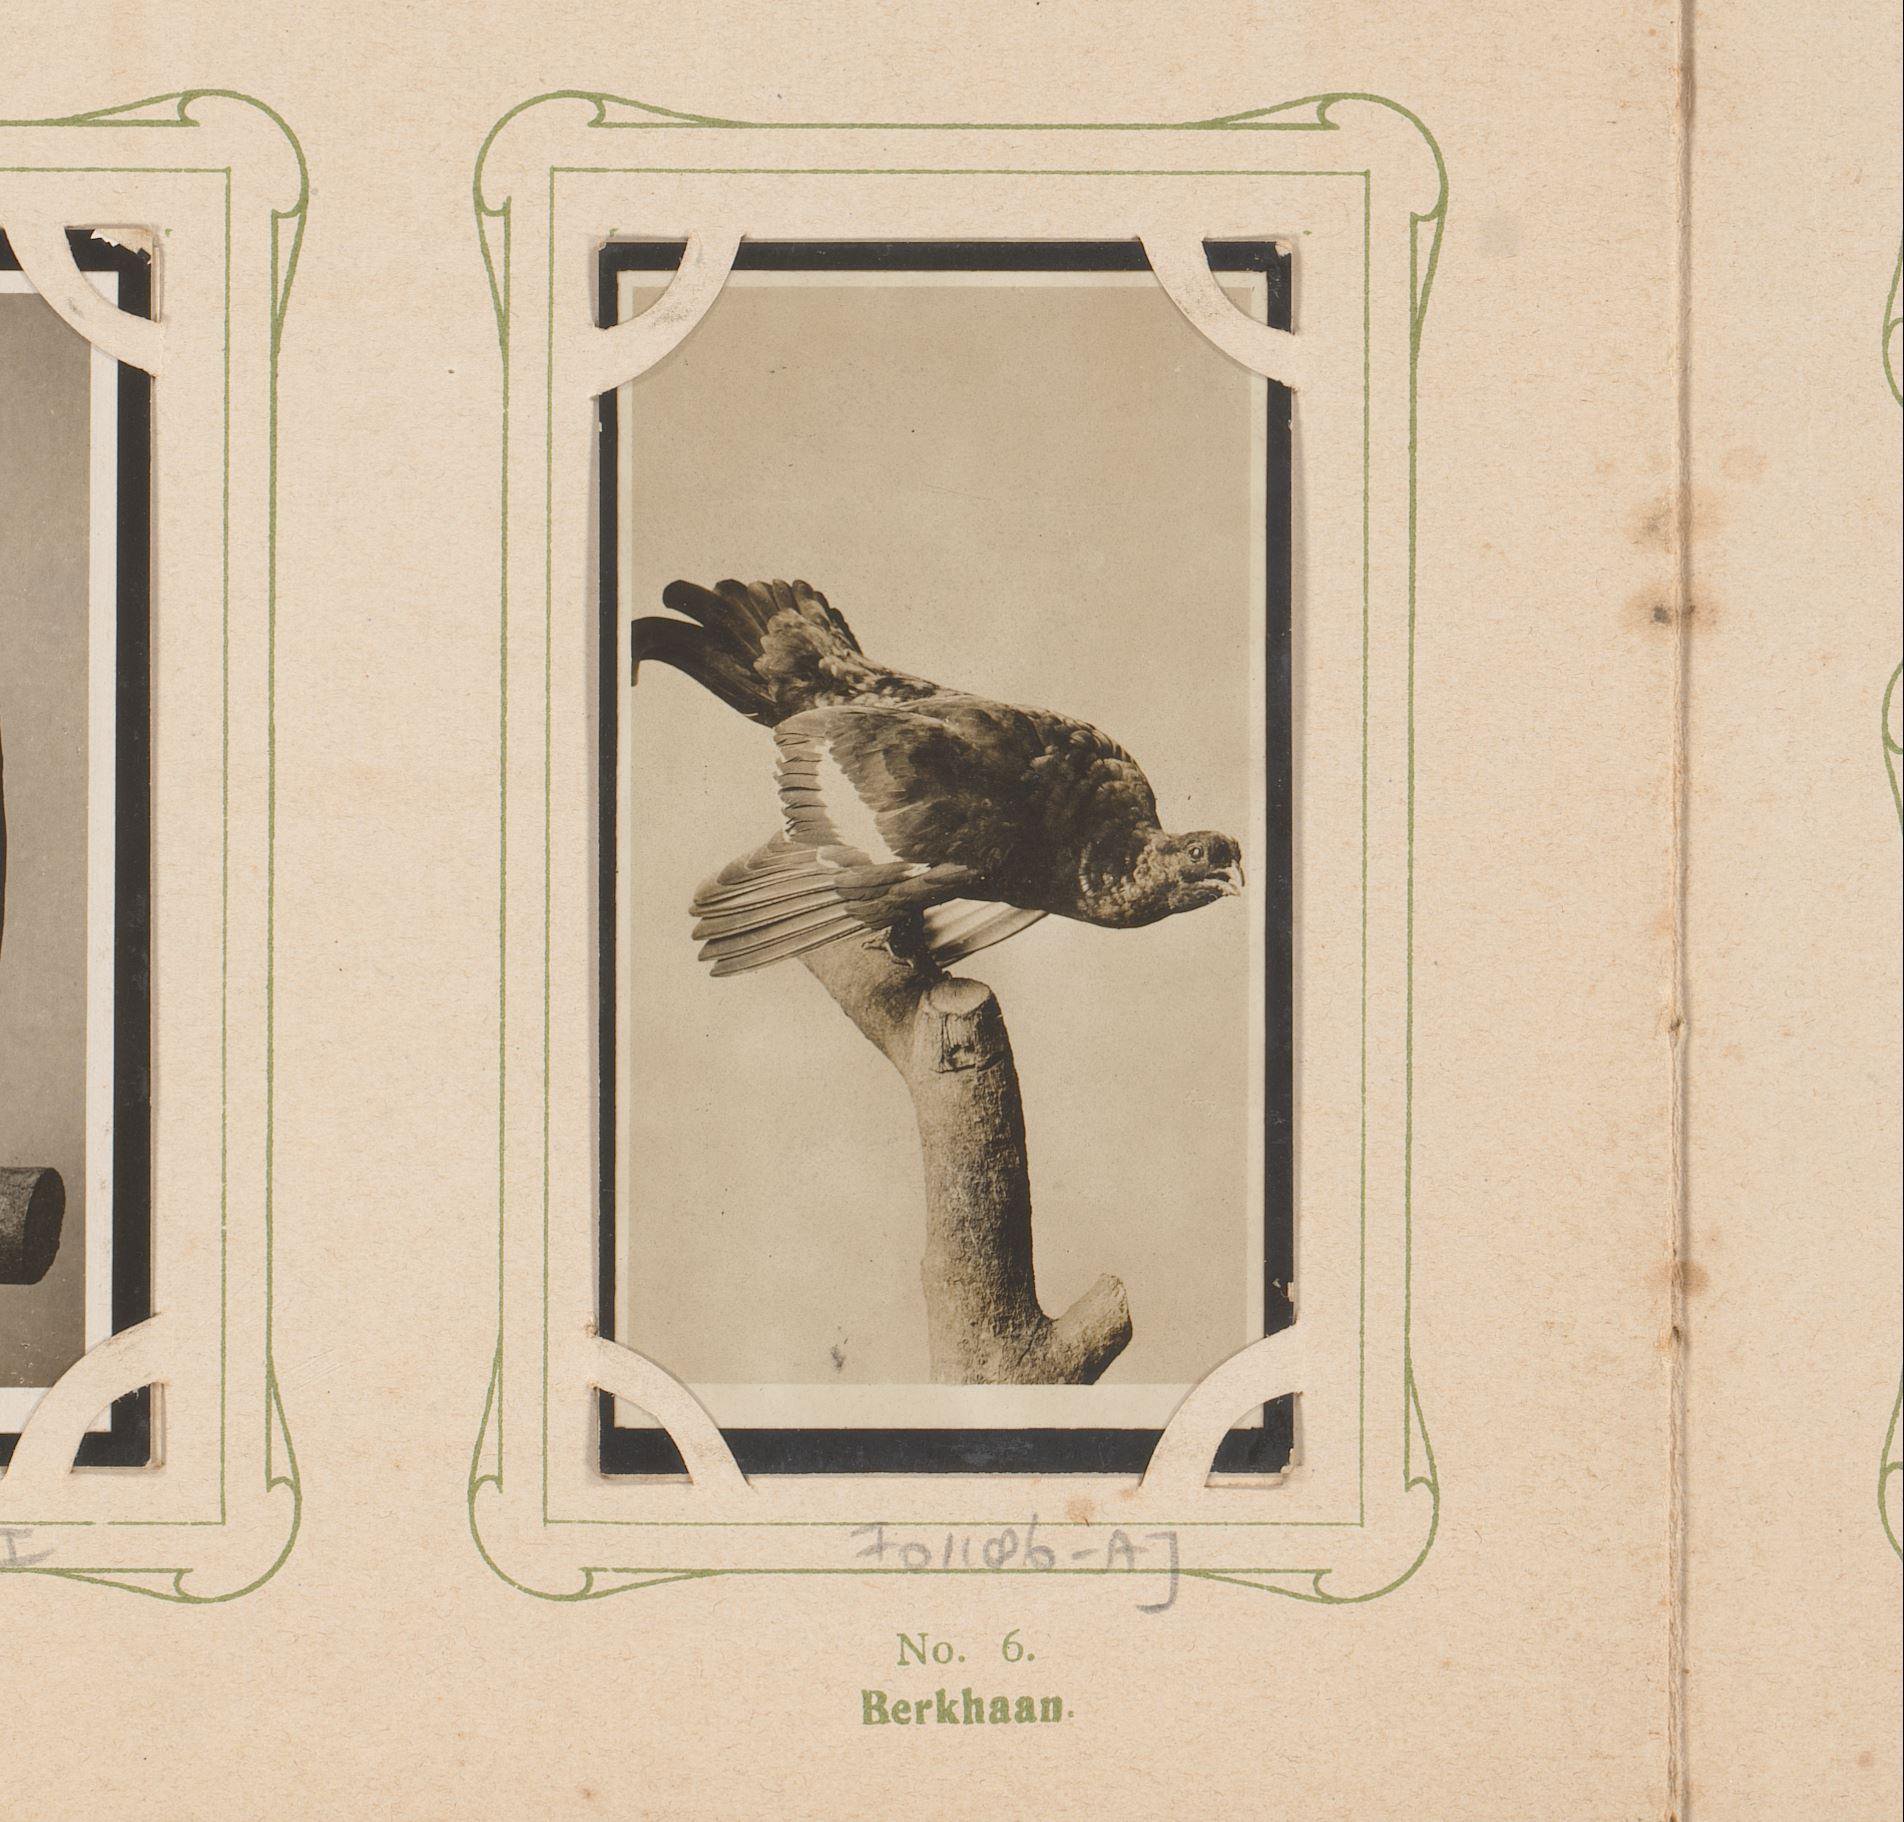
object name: album leaf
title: Hoen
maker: Anonymous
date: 1904-1905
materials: photographic support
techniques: gelatin silver print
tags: birds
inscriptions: inscription: ‘No. 6./ Berkhaan.’